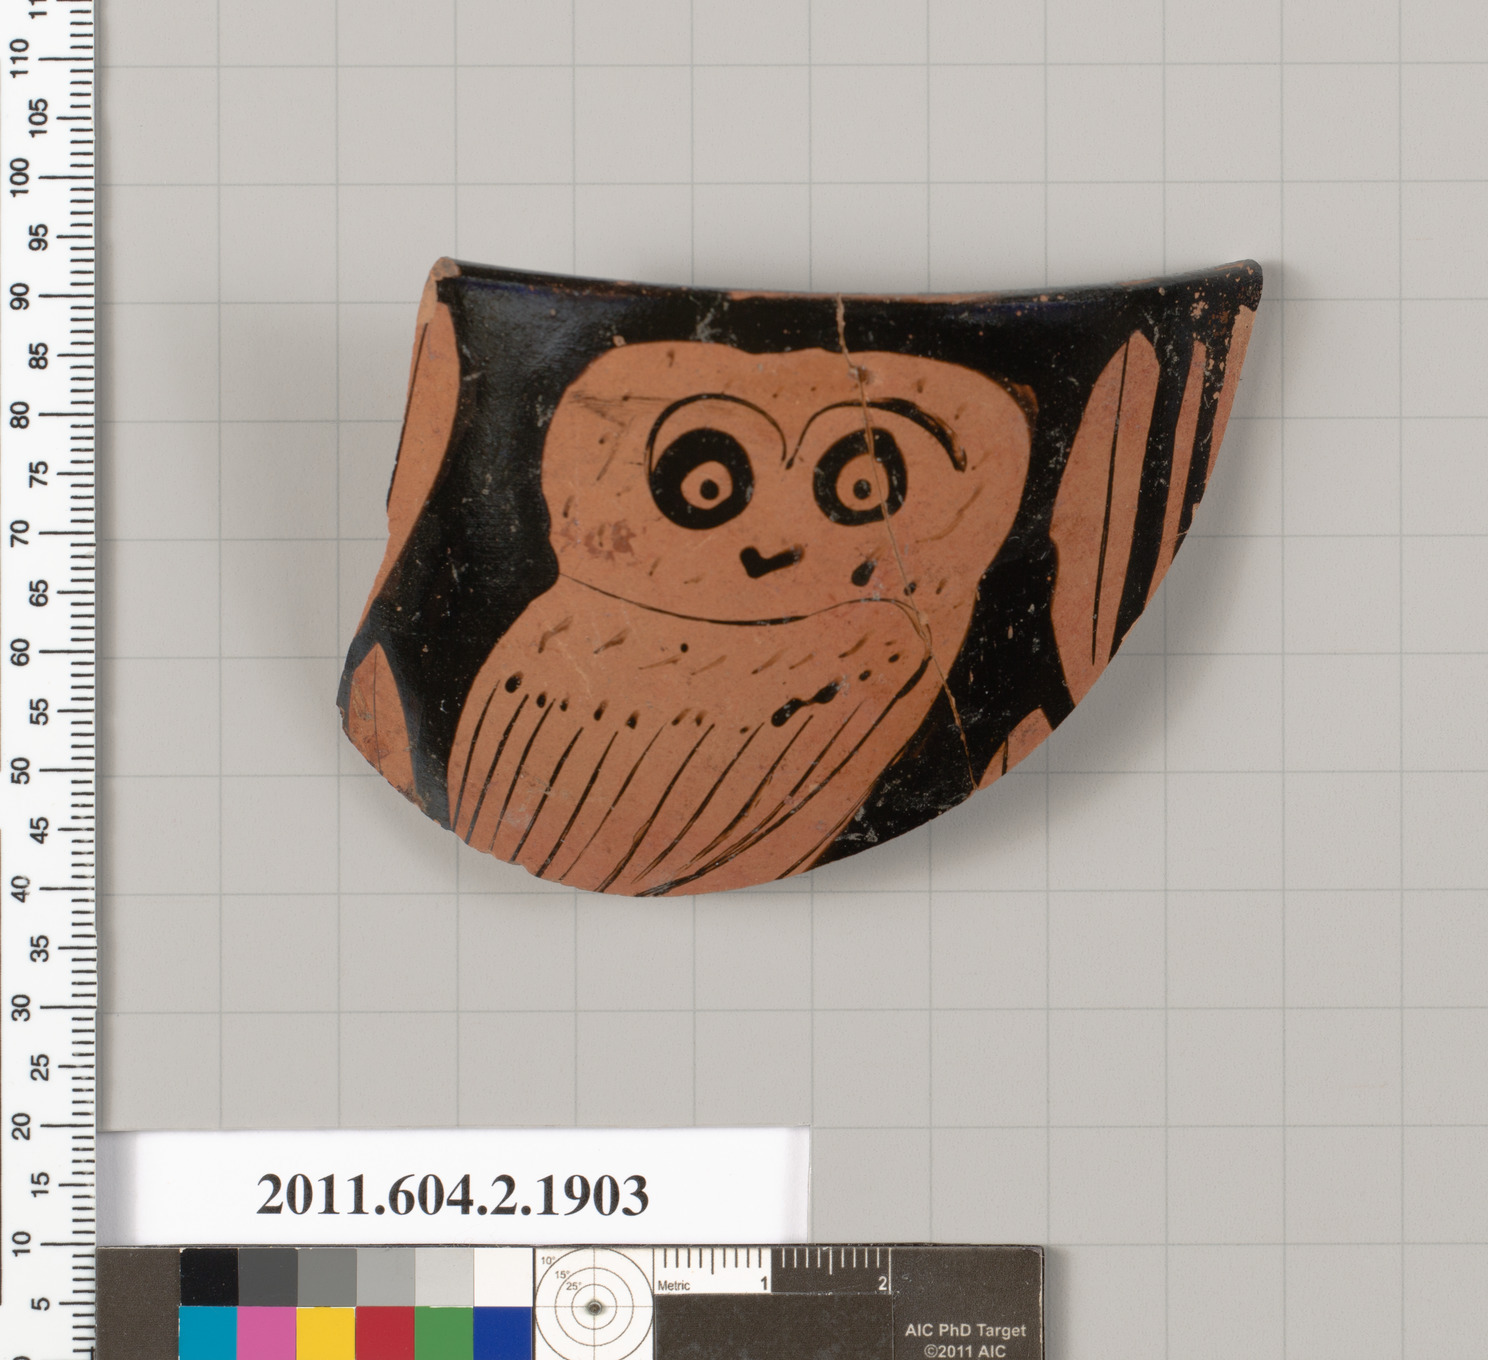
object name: skyphos fragment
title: Terracotta fragment of a skyphos (deep drinking cup)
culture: greek, attic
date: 460-430 BCE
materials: terracotta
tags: owls